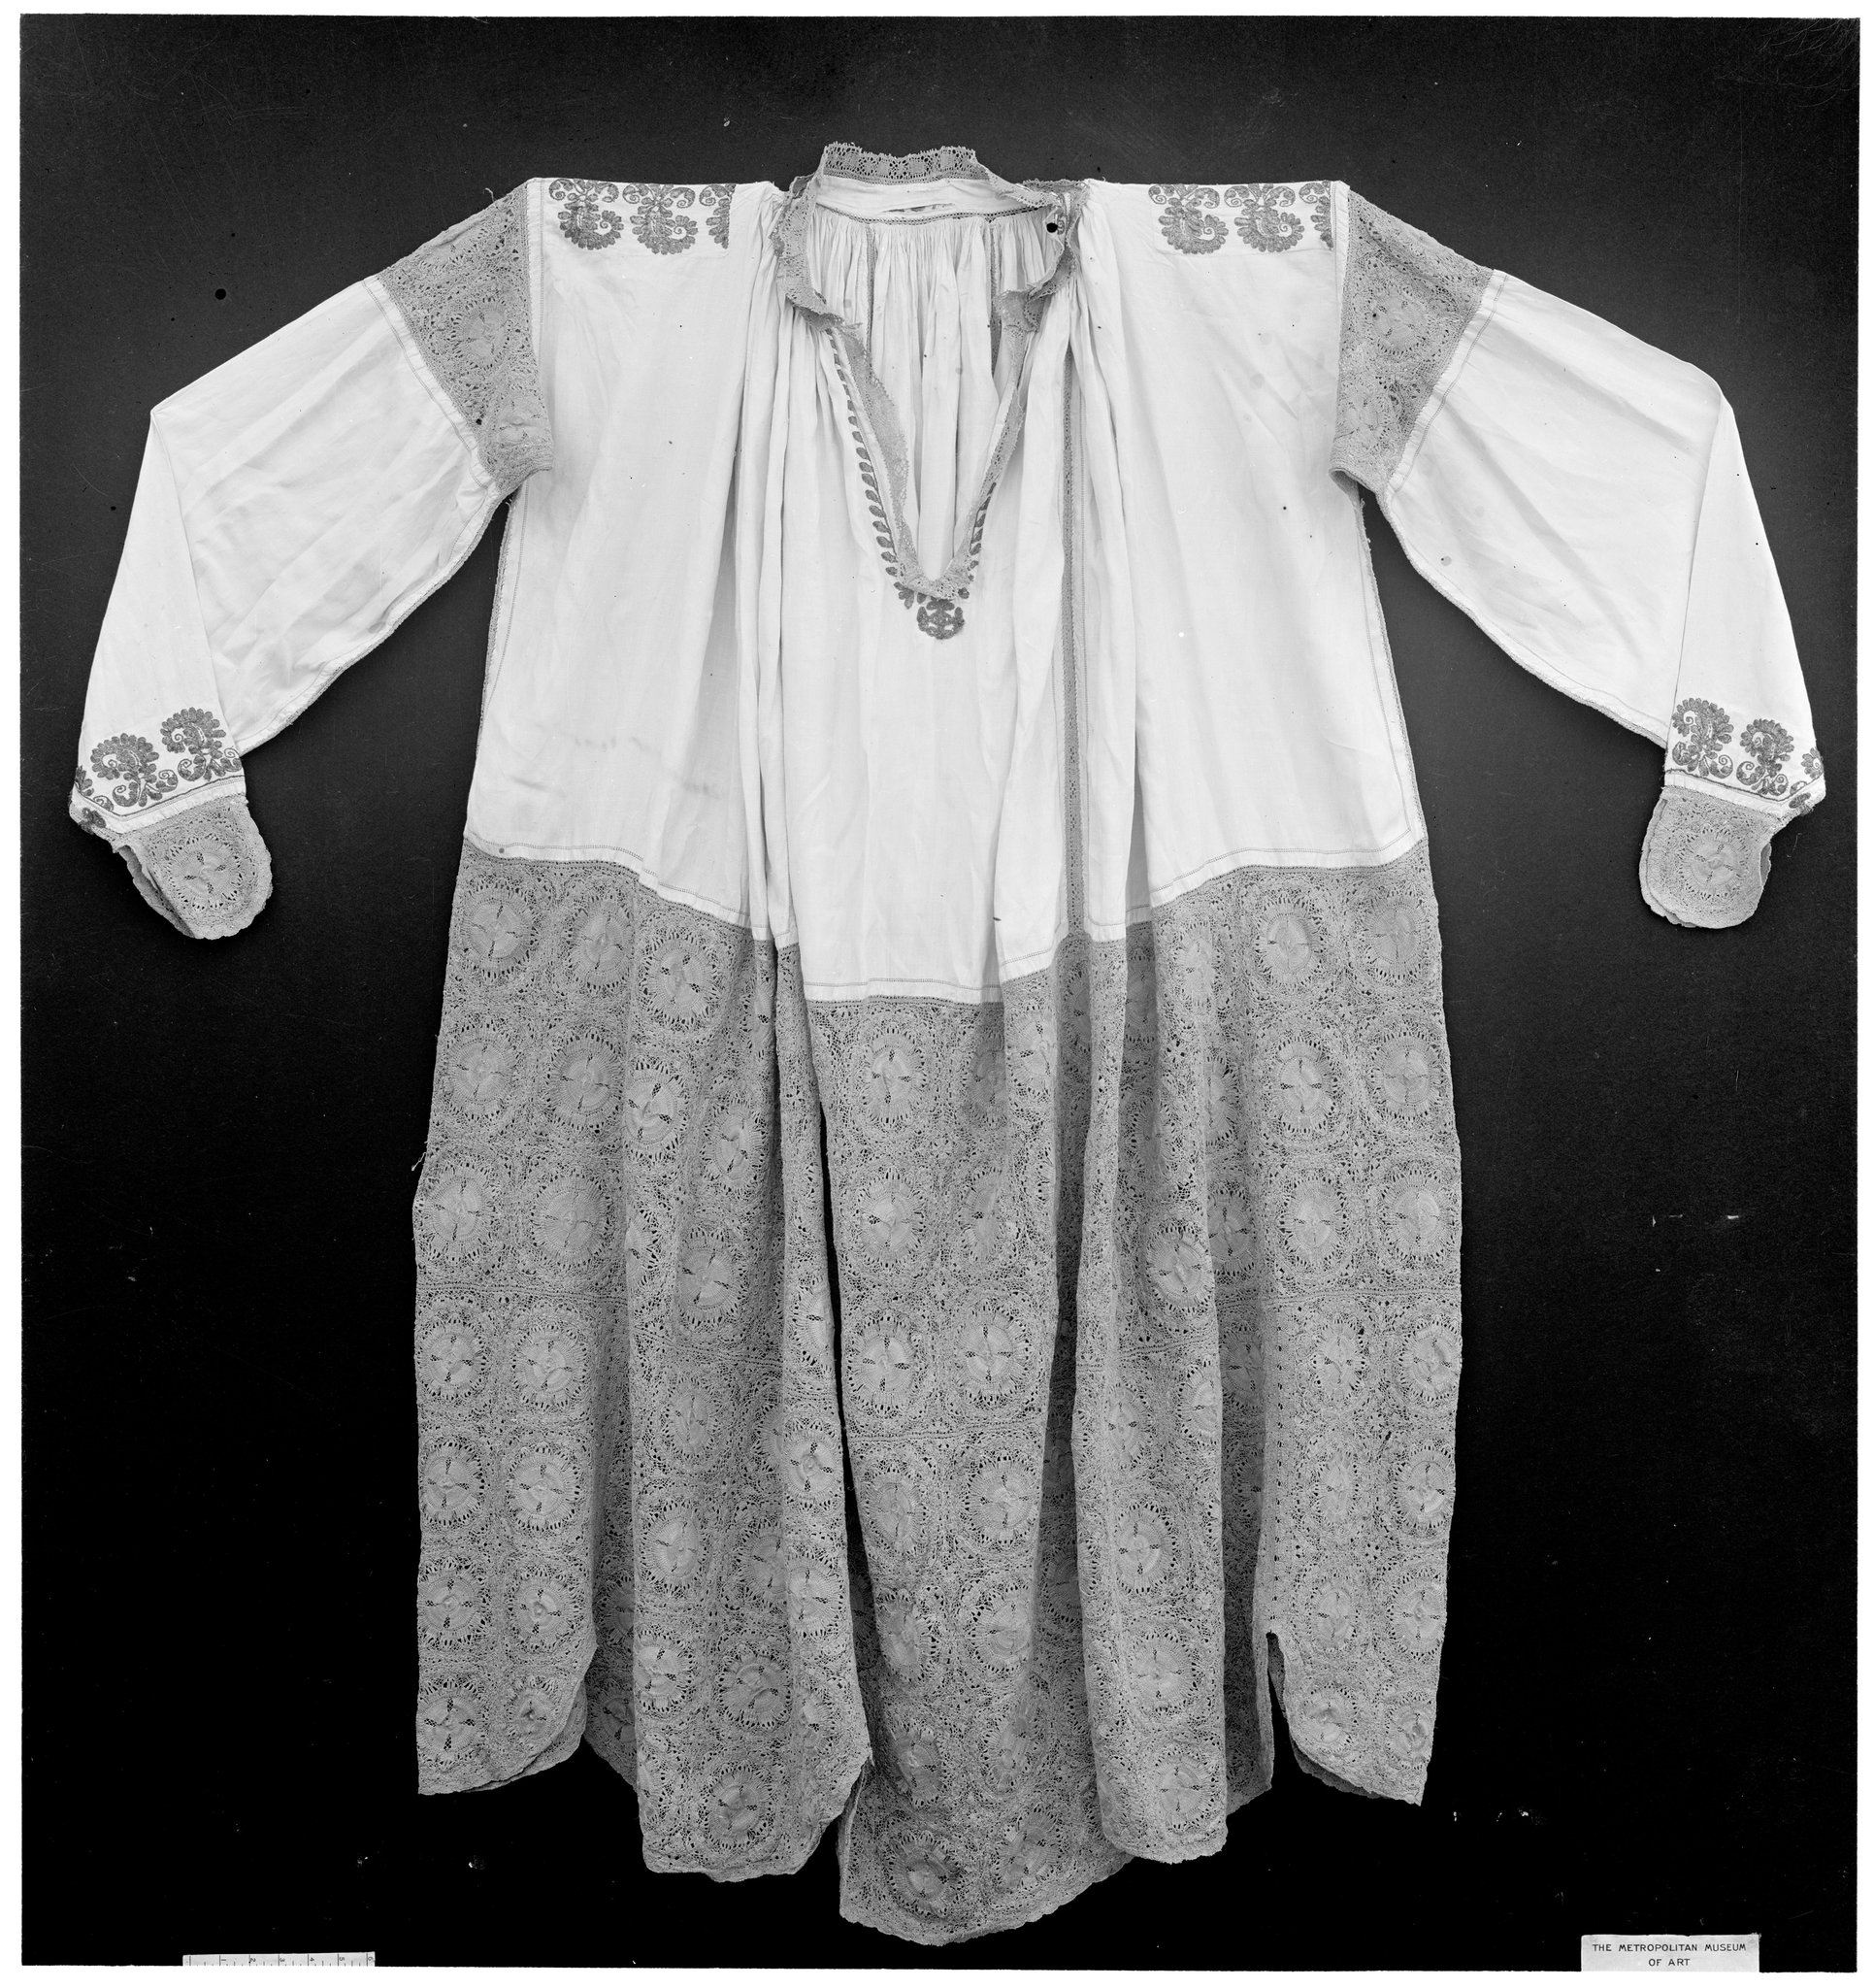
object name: alb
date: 1801-1900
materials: linen, metal thread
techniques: lace